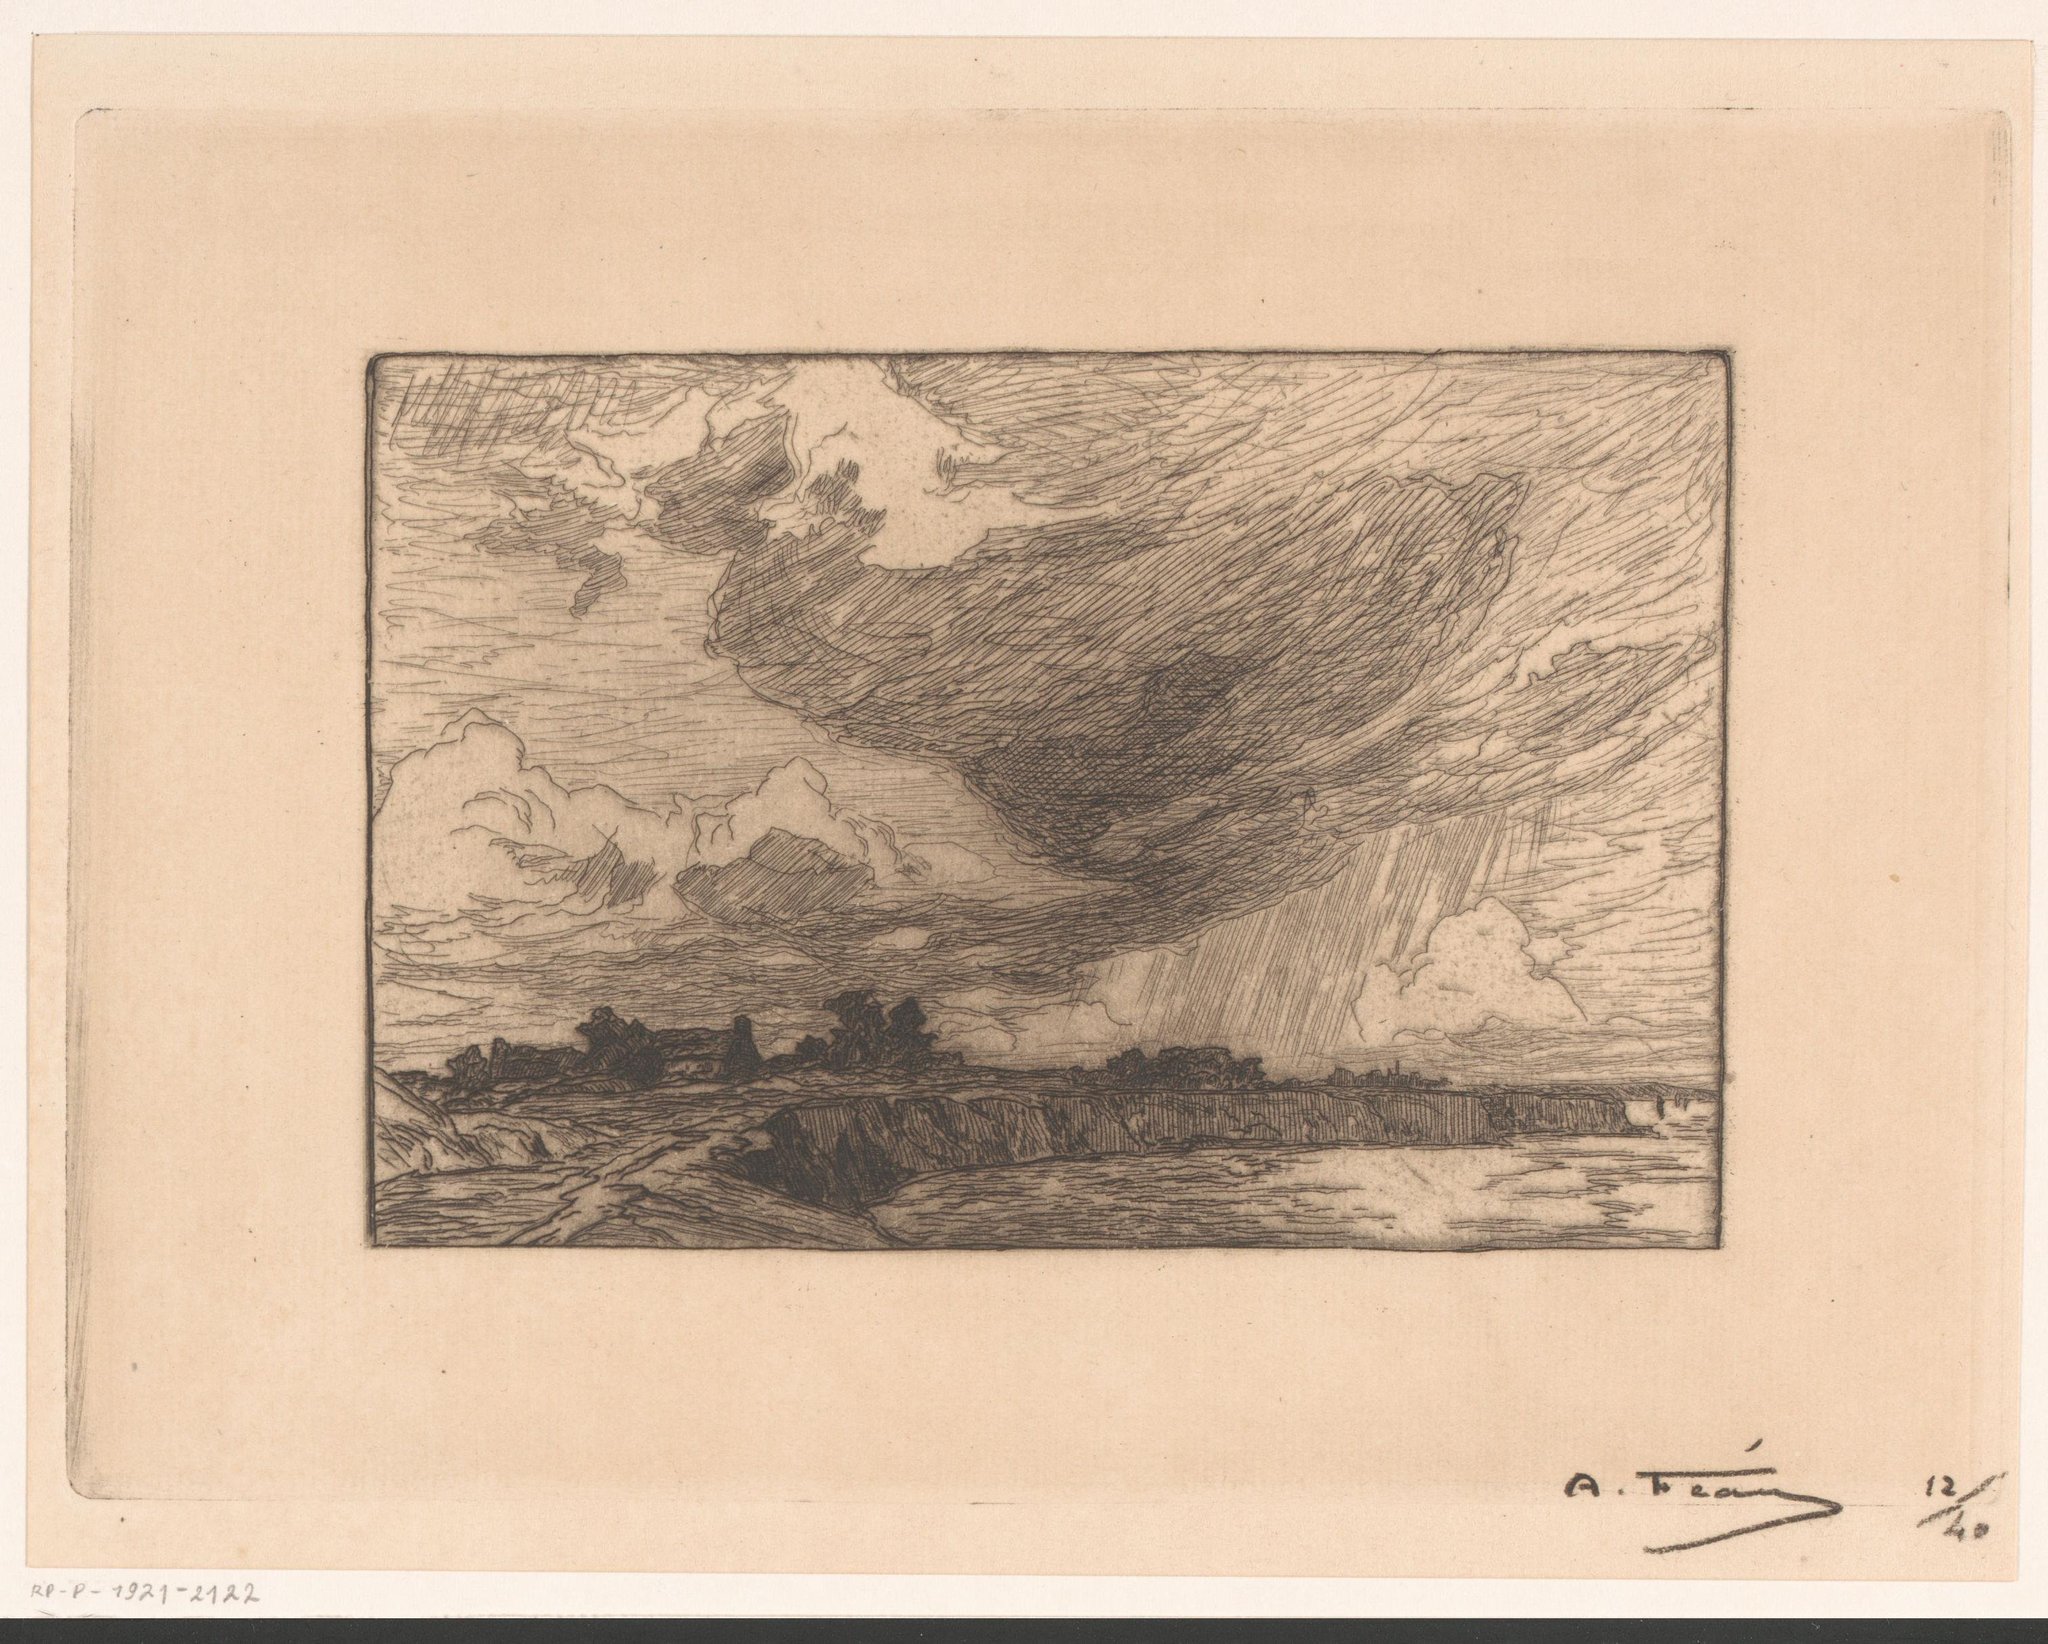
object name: print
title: Kustlijn met overtrekkende regenbui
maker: amédée féau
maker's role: print maker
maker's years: 1872-1952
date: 1882-1921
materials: paper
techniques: drypoint, etching, intaglio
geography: france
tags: downpour, rain shower, rocky coast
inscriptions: collector's mark: Lugt 2228